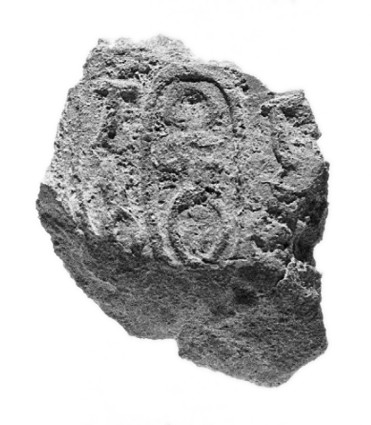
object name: sealing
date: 1981-1640 BCE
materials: mud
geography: egypt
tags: hieroglyphs